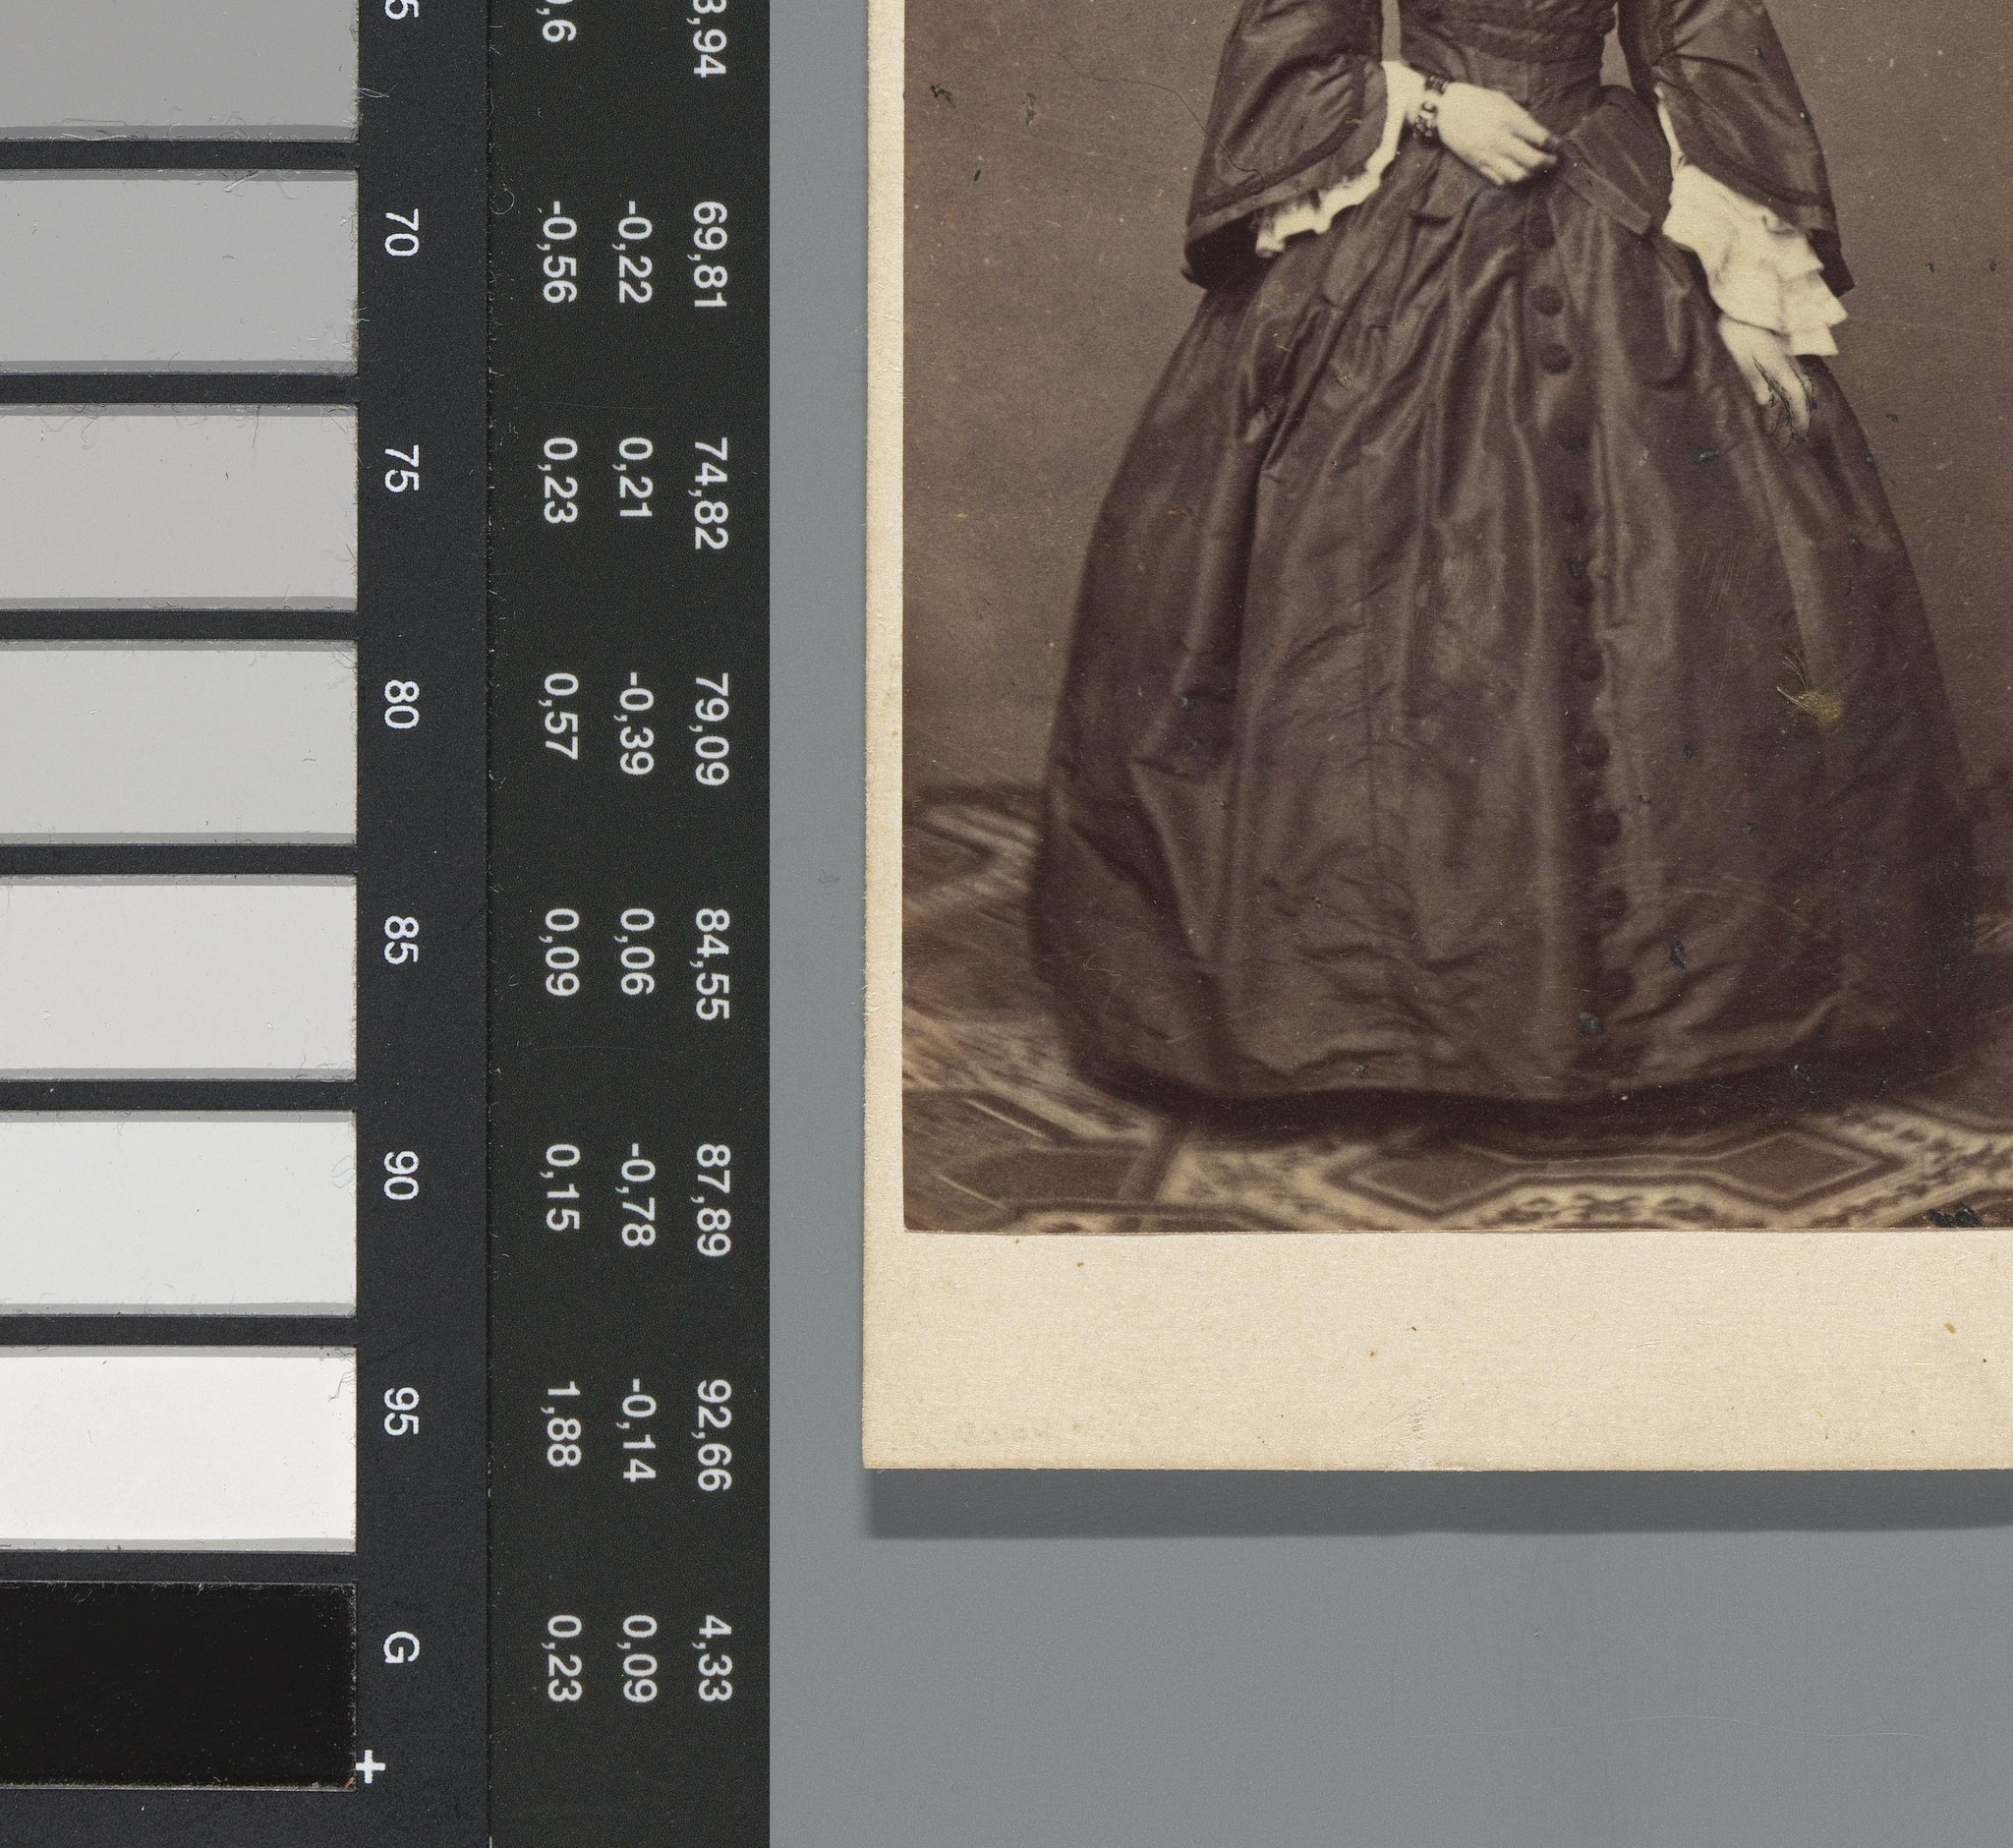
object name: carte de visite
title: Portret van tante Jans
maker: gerrit hoogwinkel jr.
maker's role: fotograaf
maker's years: 1837-1890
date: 1855-1910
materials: cardboard, photographic support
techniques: albumen print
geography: rotterdam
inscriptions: name: ‘G. HOOGWINKEL / Photographe / ROTTERDAM.’, name: ‘Tante Jans’